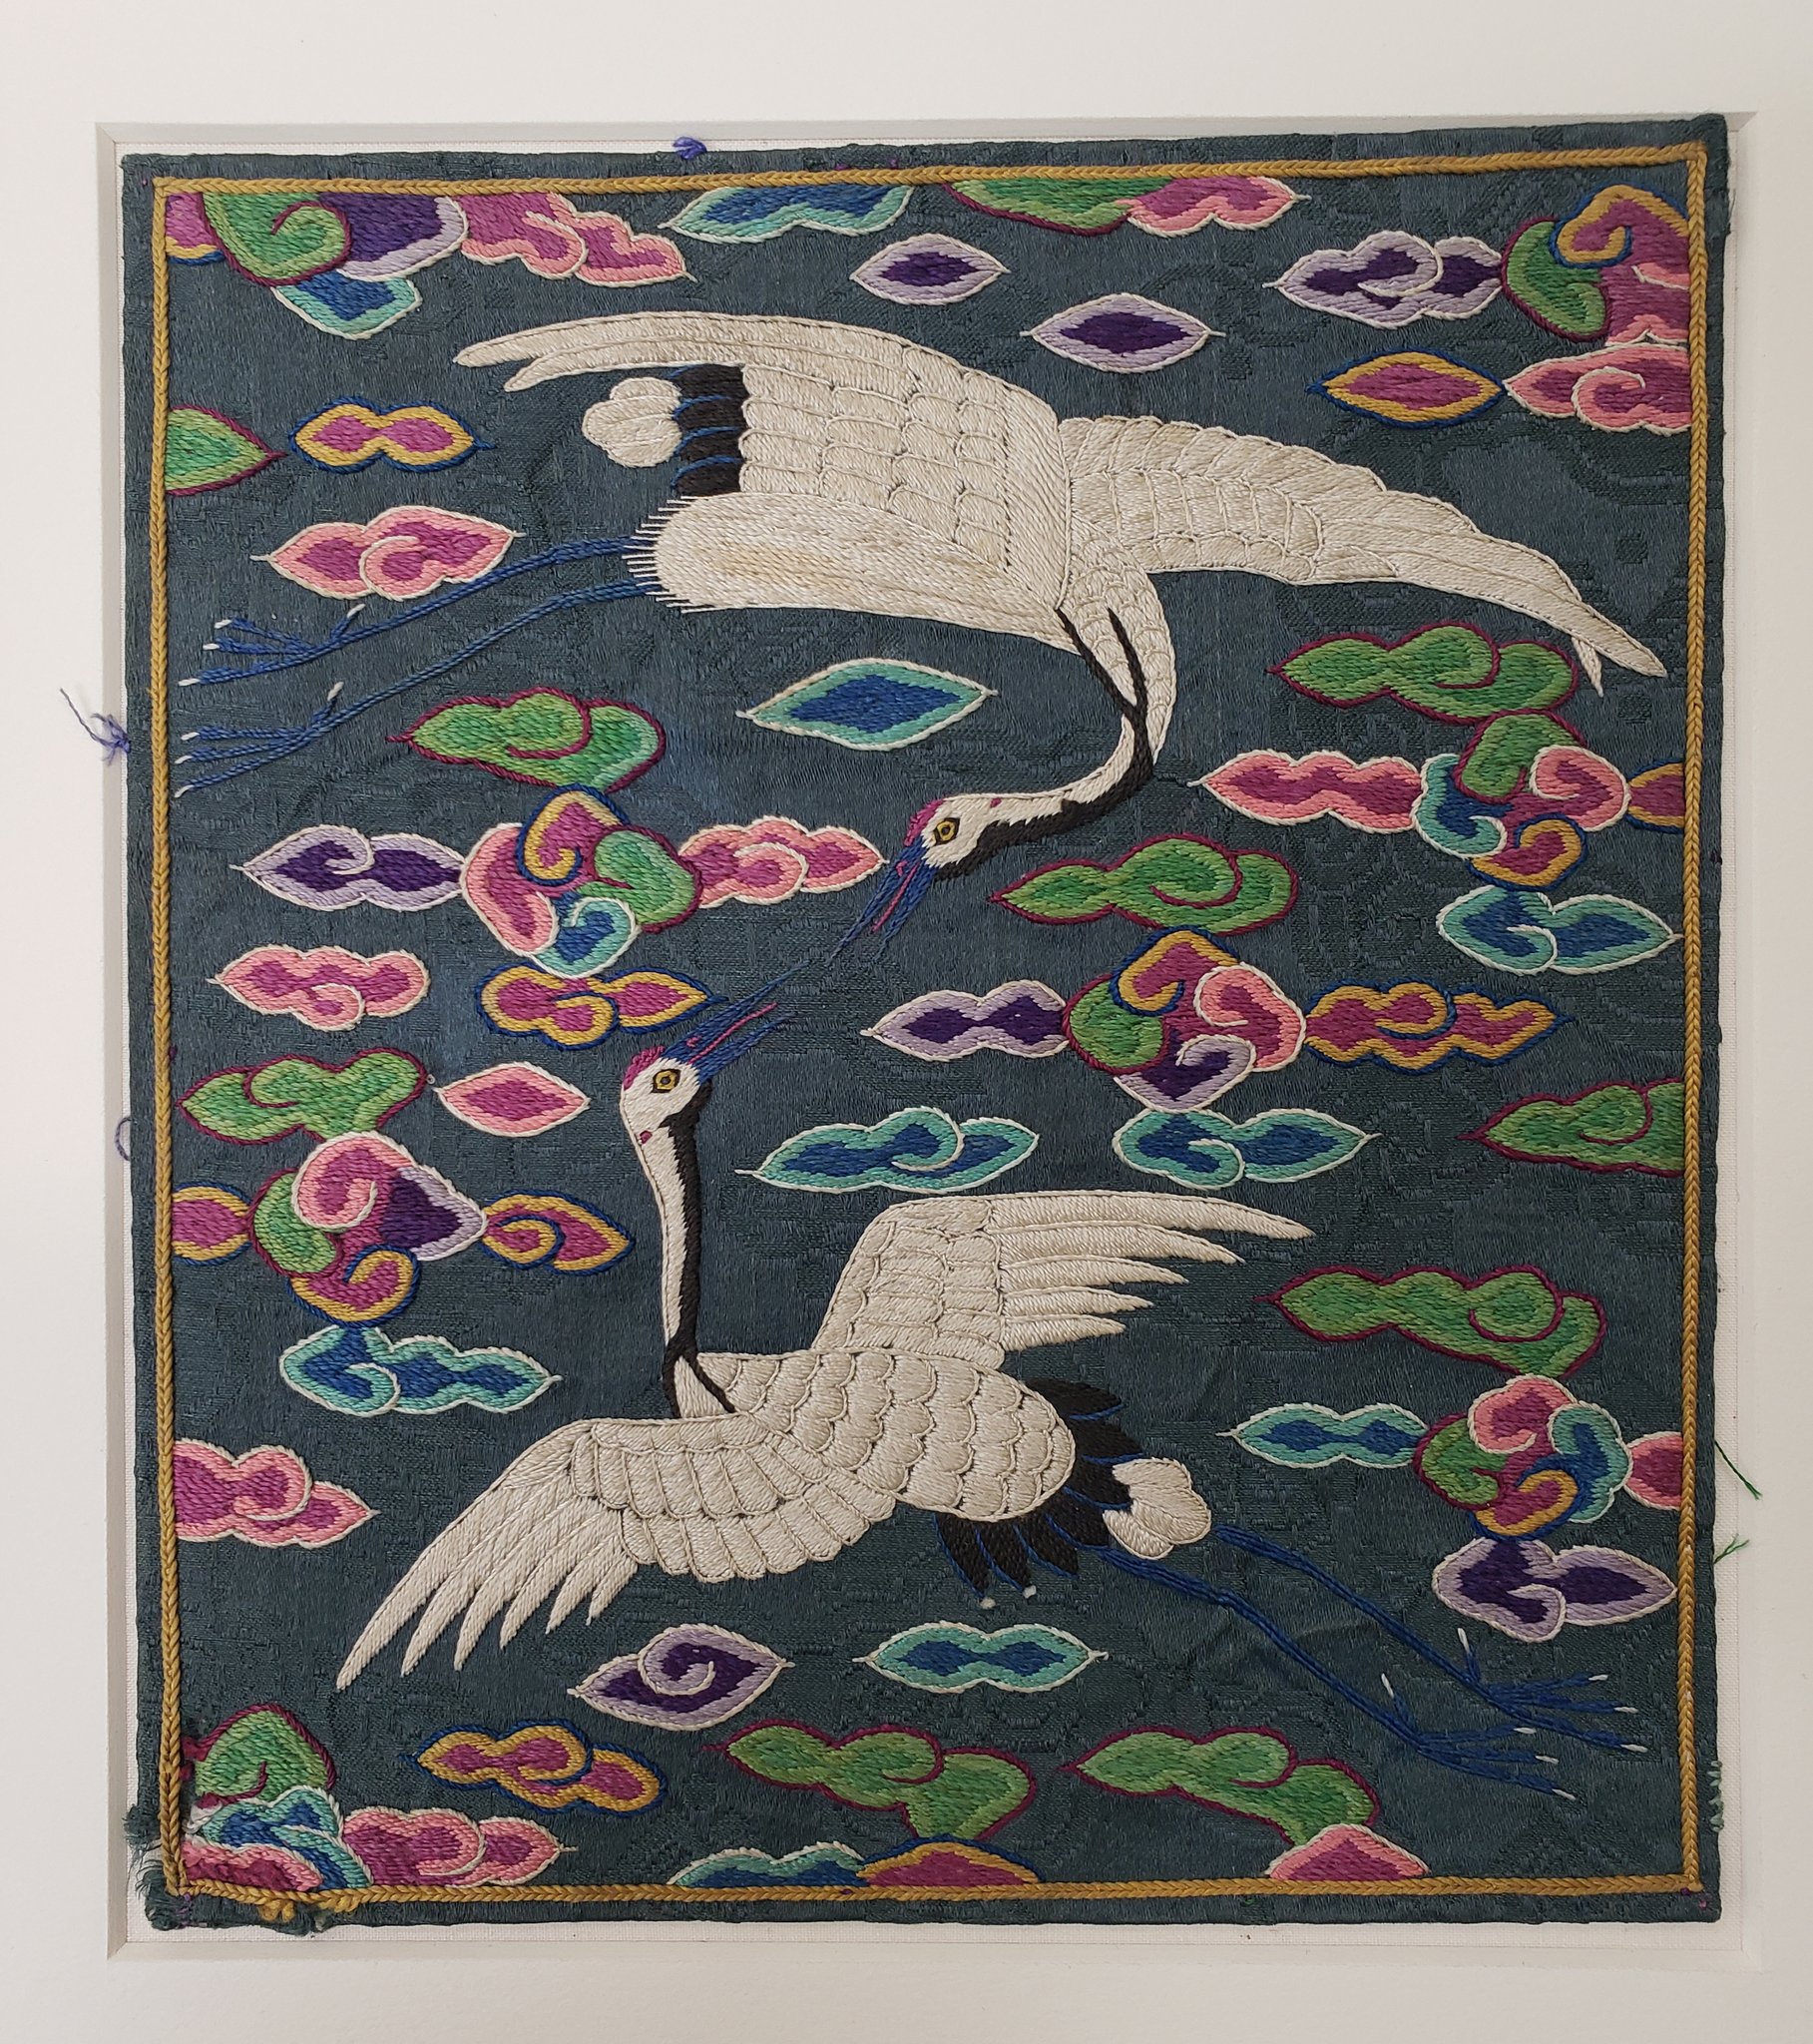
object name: rank badge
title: Civil-Official Hyungbae (Rank Badge)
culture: korean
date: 1867-1900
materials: silk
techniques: damask, embroidery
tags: cranes